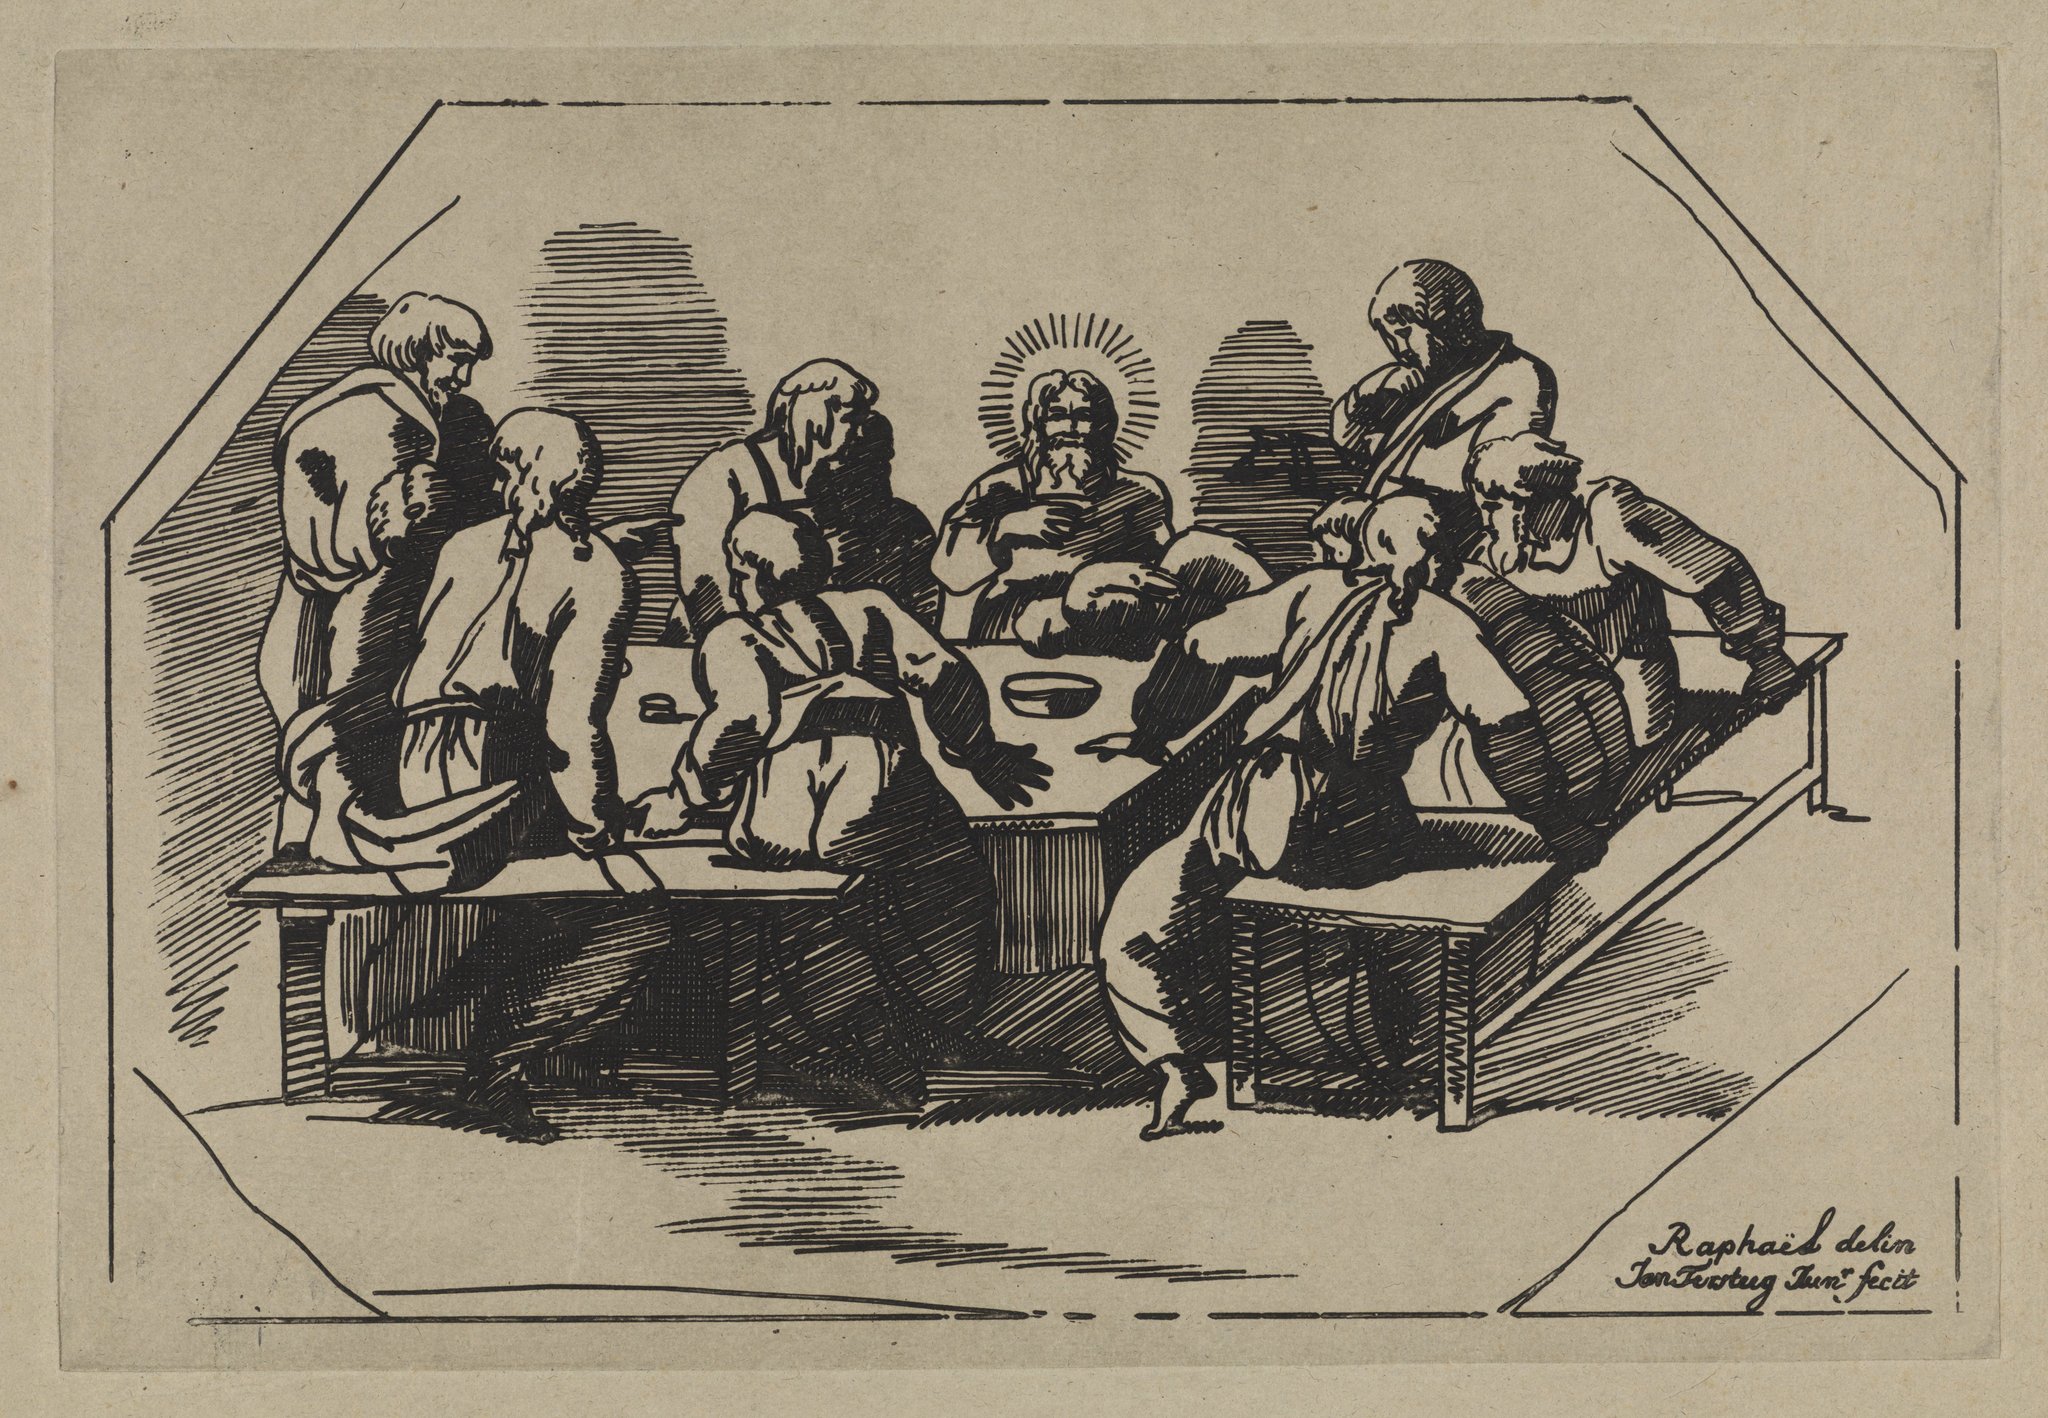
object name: print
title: Laatste avondmaal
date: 1765-1807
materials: paper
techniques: etching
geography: amsterdam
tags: announcement of the betrayal of christ, and the reaction of the apostles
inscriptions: collector's mark: Lugt 2228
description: Het laatste avondmaal van Christus met zijn leerlingen. De leerlingen schrikken van de aankondiging dat een van hen Christus zal verraden.